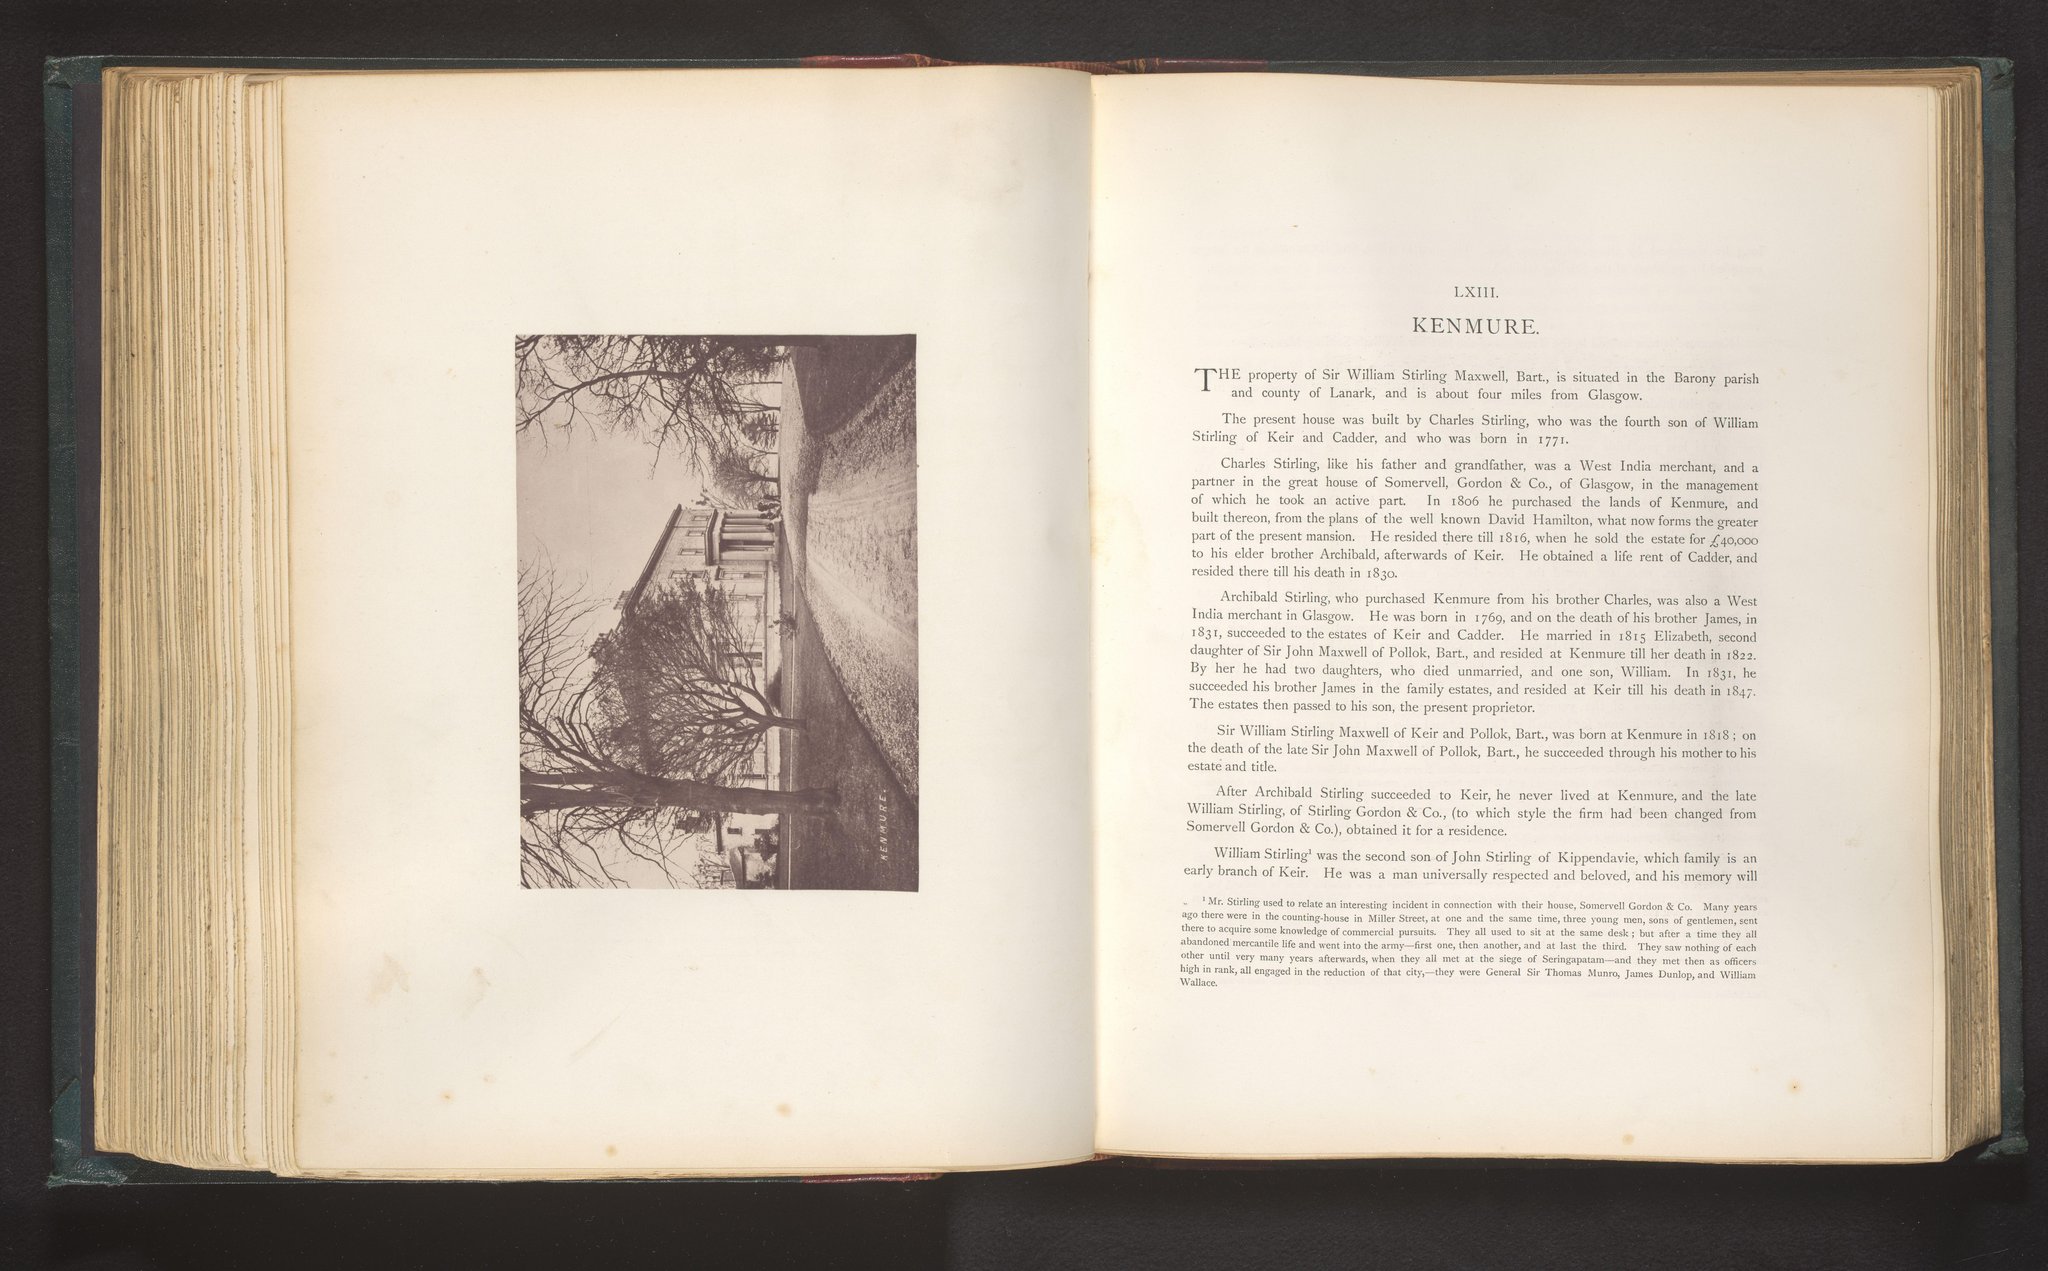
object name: photograph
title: Kenmure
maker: thomas annan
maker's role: fotograaf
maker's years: 1829-1887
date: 1868-1878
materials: paper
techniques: carbon print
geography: scotland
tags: castle, façade (of house or building)